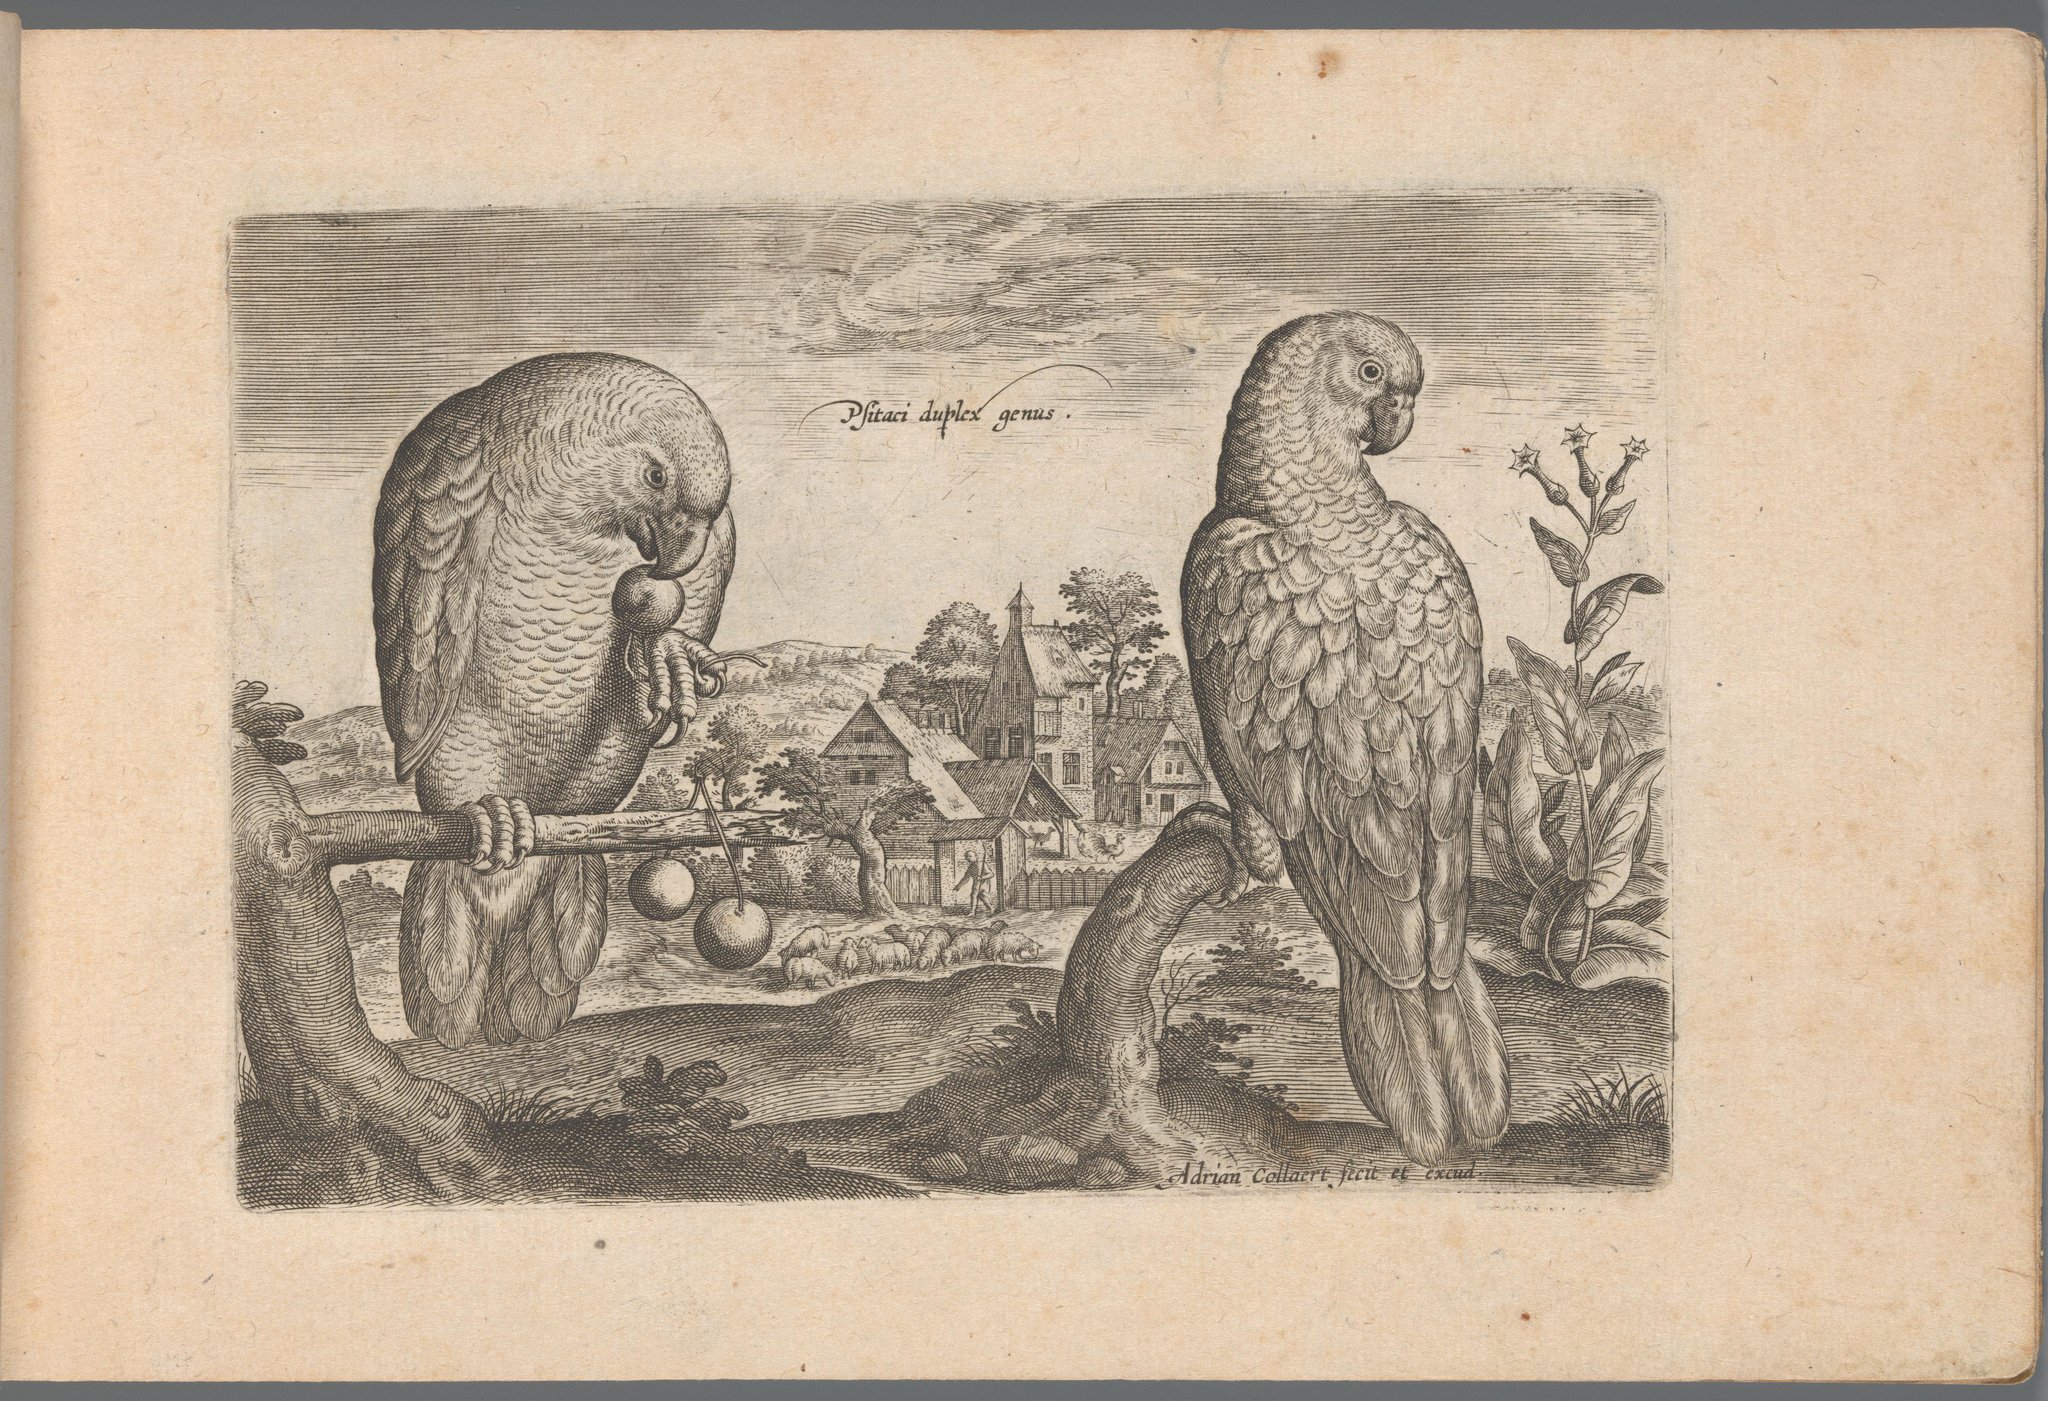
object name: print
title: Psitaci duplex genus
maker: adriaen collaert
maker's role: draughtsman, print maker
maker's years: 1560-1618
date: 1570-1600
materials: paper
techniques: engraving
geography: antwerp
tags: ornamental birds: parrot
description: Twee grijze roodstaart papegaaien in een landschap met een boerderij. Prent is onderdeel van een prentalbum met zeven prenten van vogels en de titelprent.